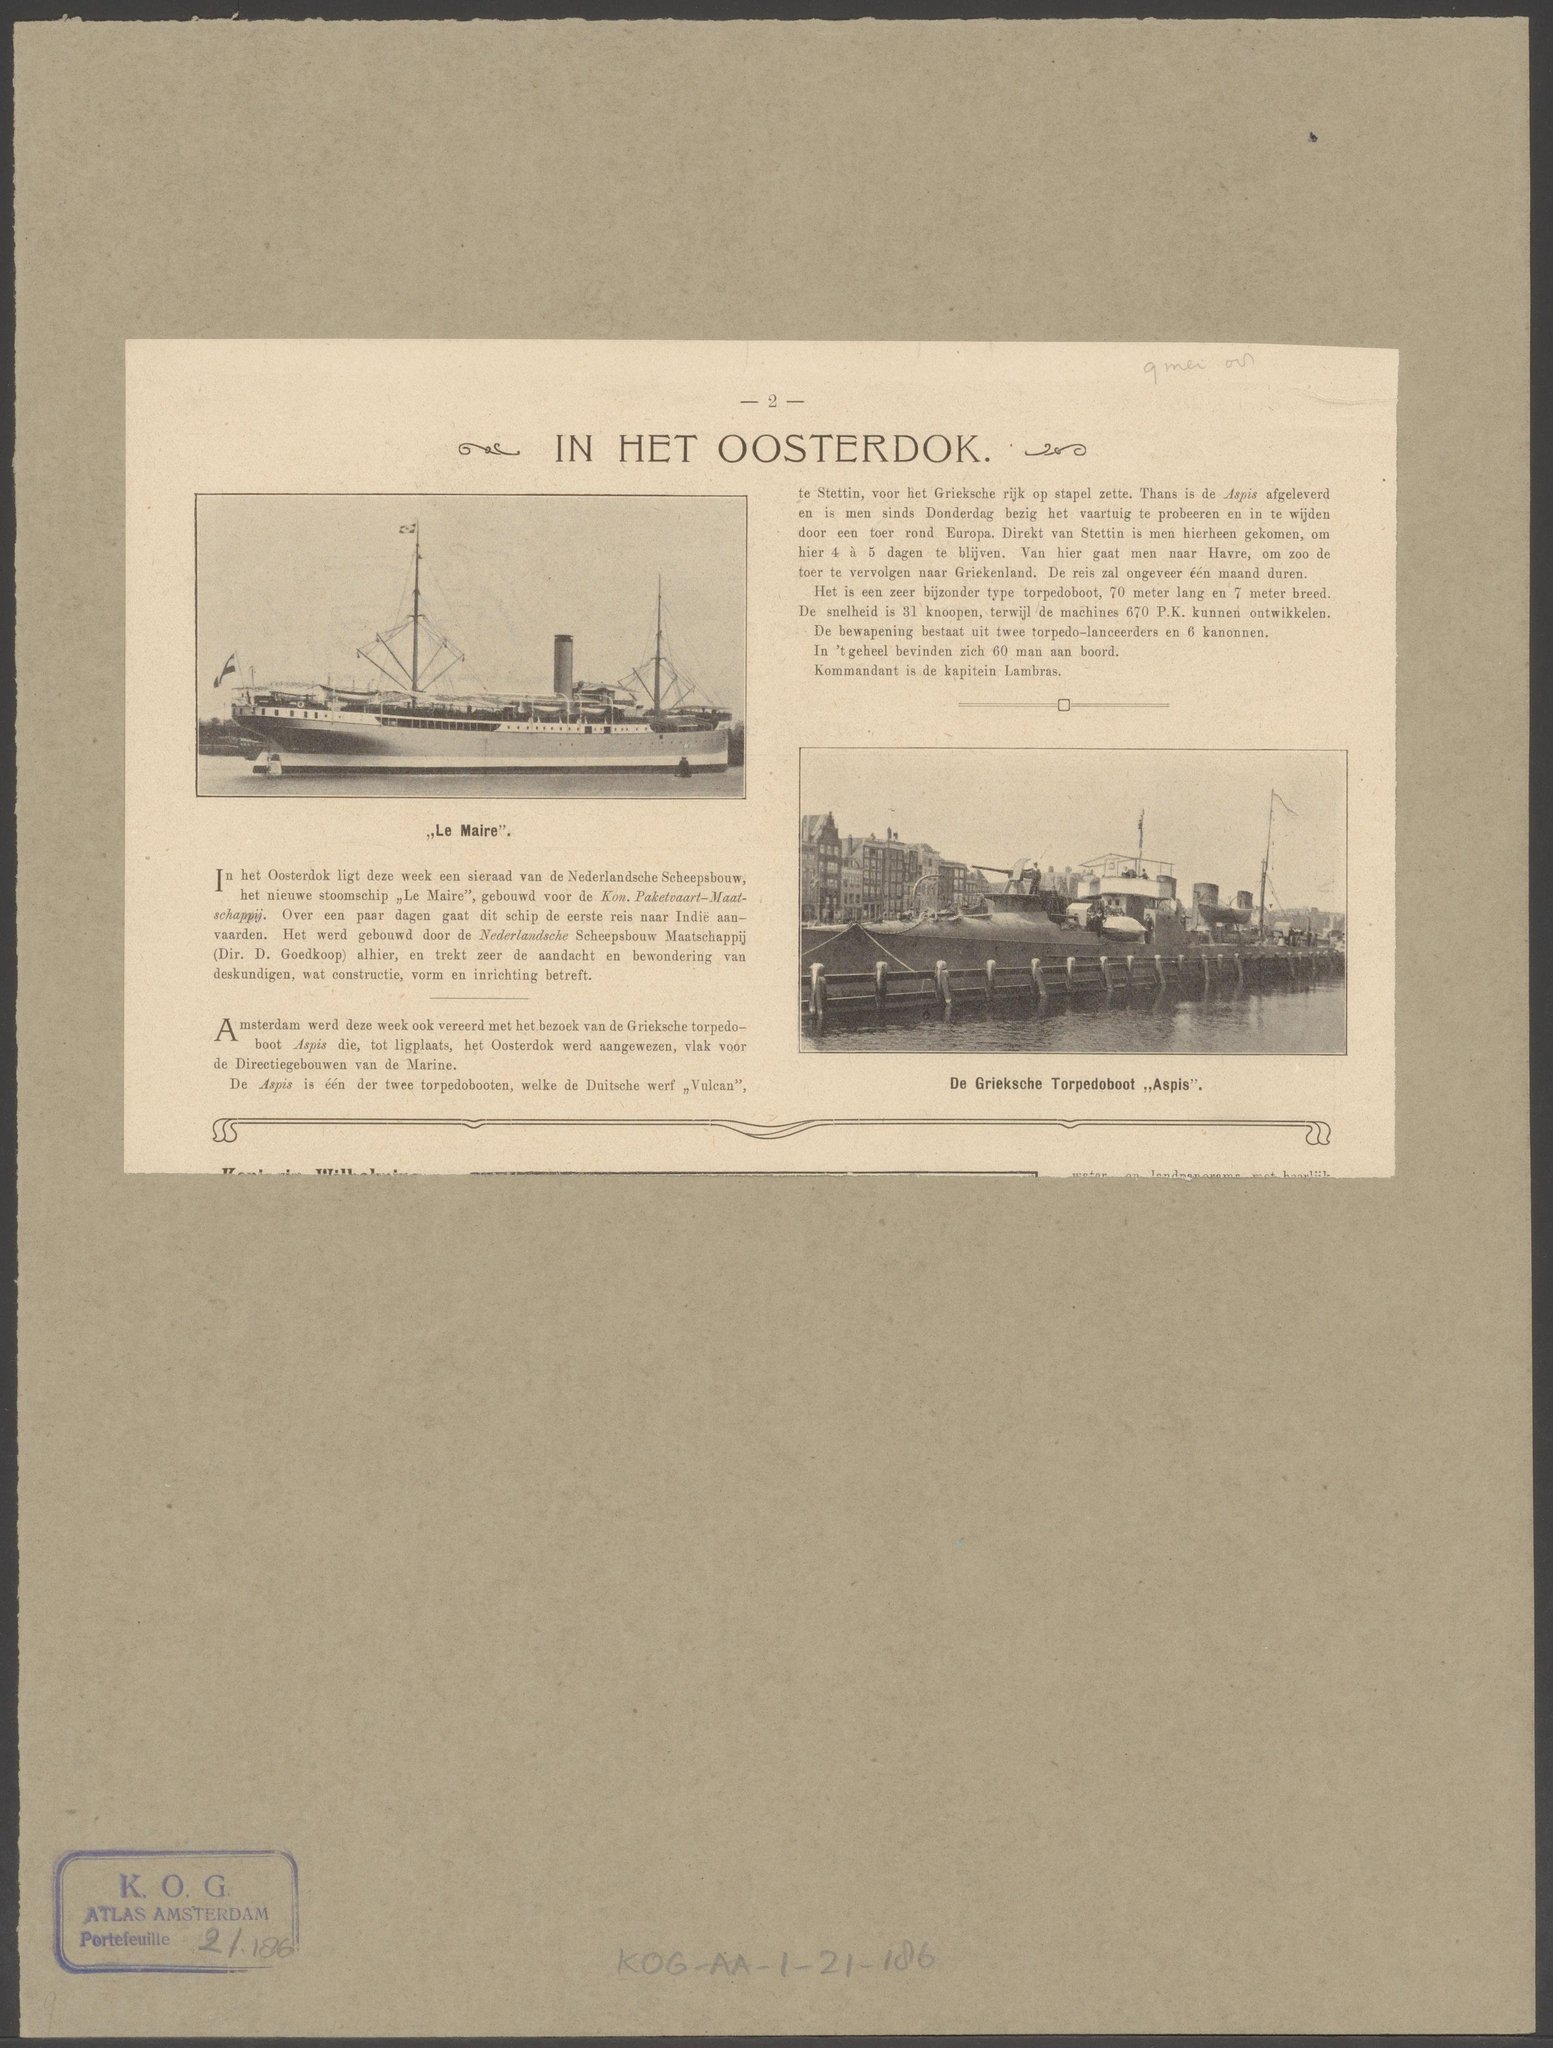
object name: photomechanical print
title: Schepen Le Maire en Aspis in het Oosterdok te Amsterdam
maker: Anonymous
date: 1908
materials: paper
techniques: letterpress printing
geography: netherlands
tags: ships (in general) - cc - more than one ship, shipbuilding industry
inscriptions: collector's mark: ‘21.186’ Lugt 1641b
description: Blad uit: Van week tot week, bijblad van Eigen Haard (1908), 9 mei 1908.